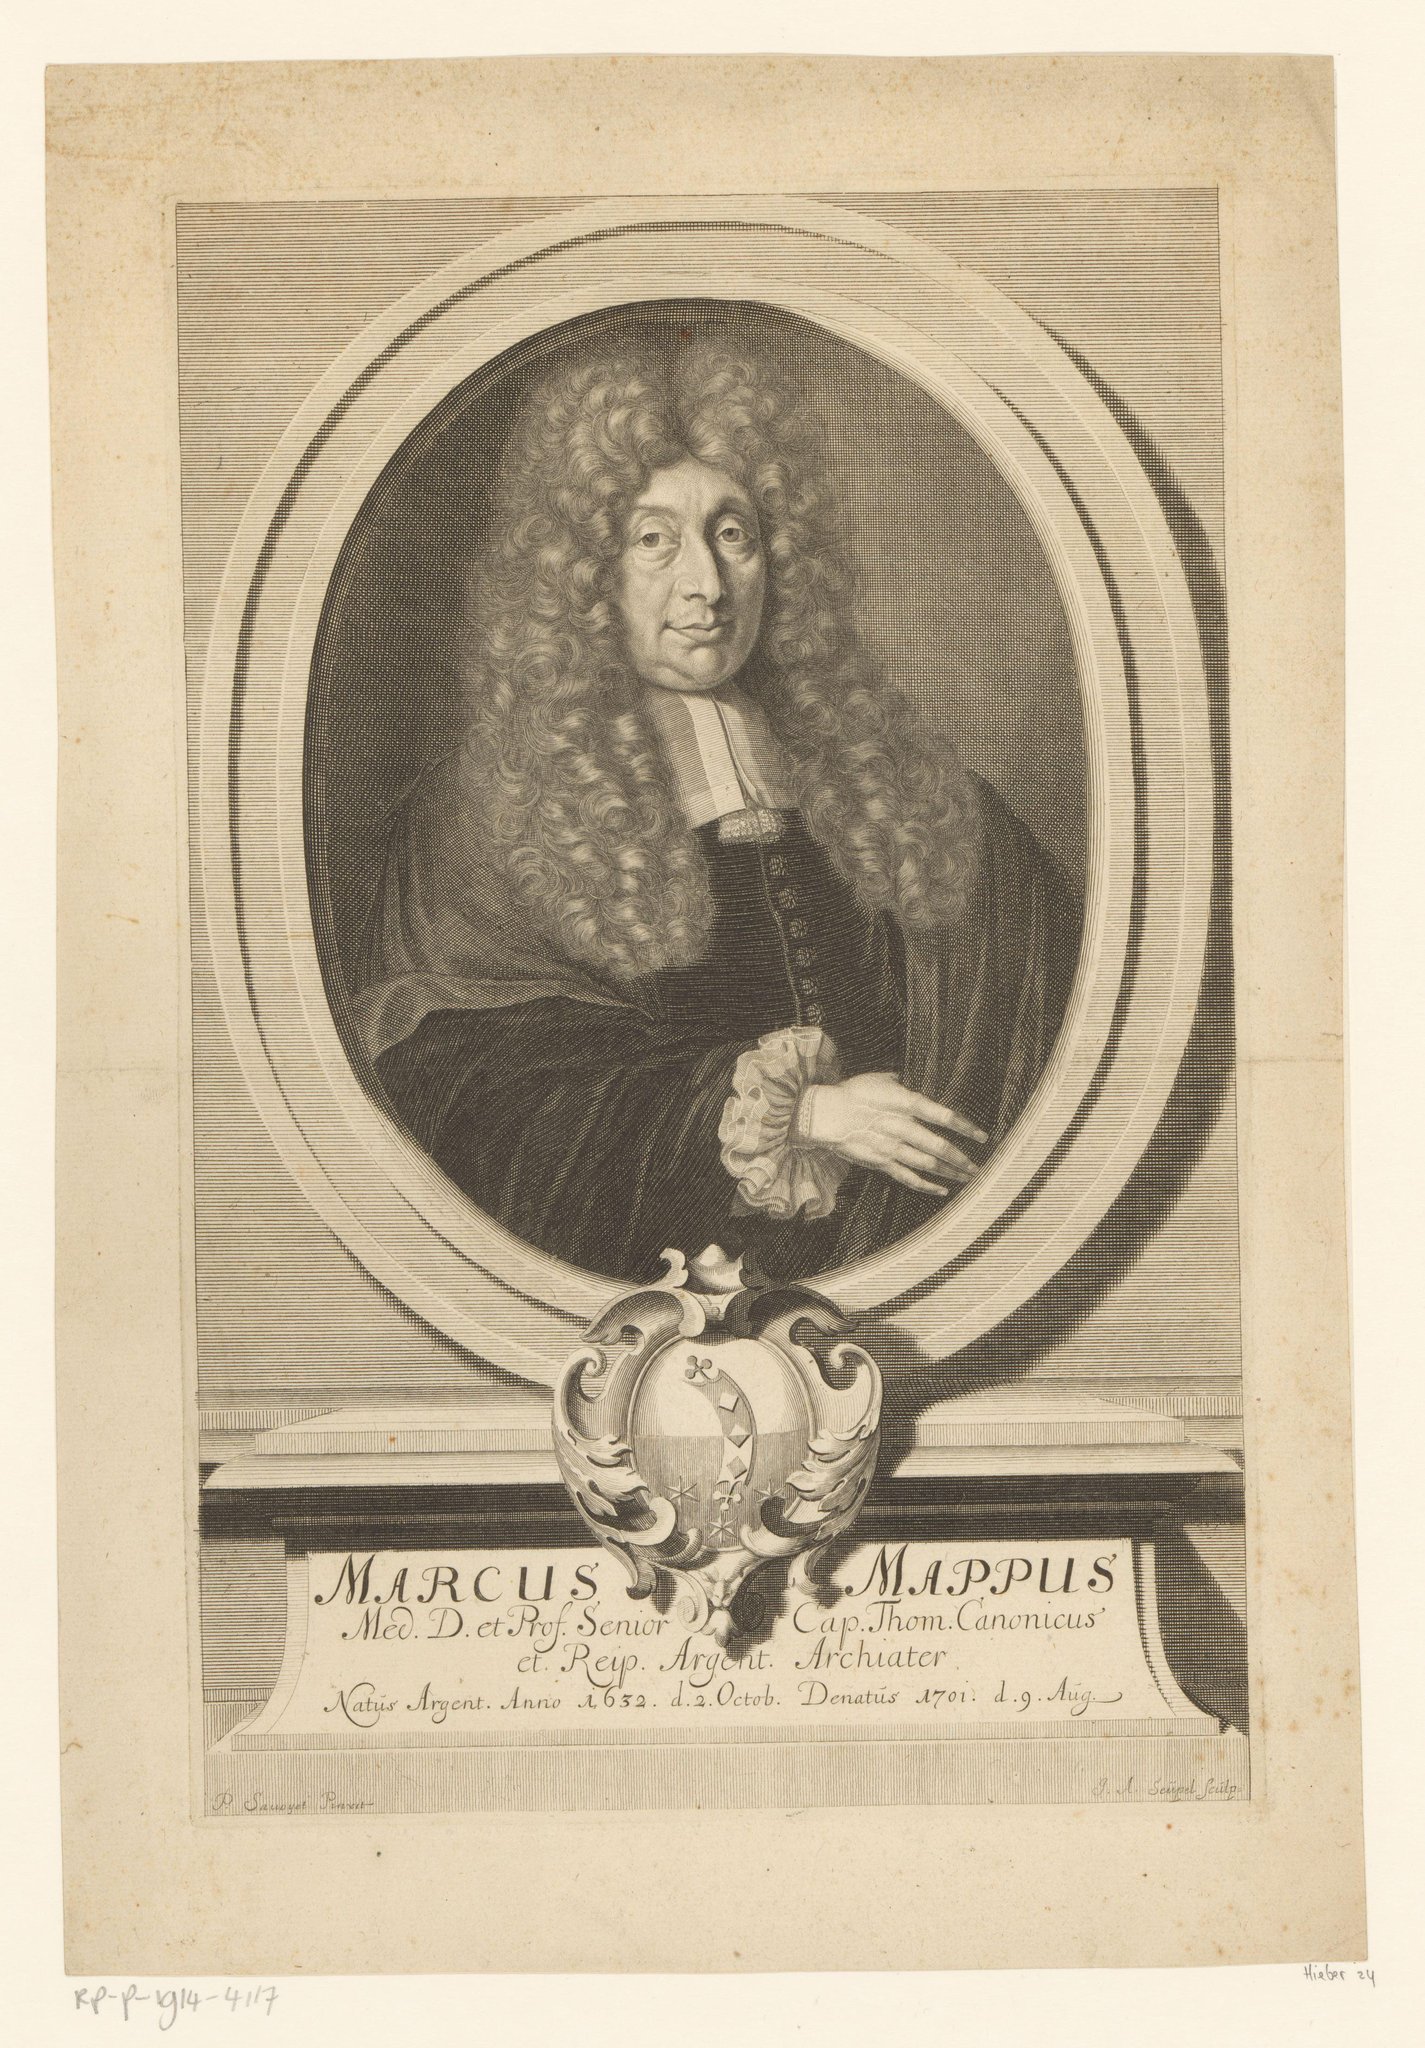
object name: print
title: Portret van Markus Mappus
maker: johann adam seupel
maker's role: painter, print maker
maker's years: 1662-1717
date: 1672-1717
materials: paper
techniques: engraving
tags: historical persons, armorial bearing, heraldry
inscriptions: collector's mark: Lugt 2228